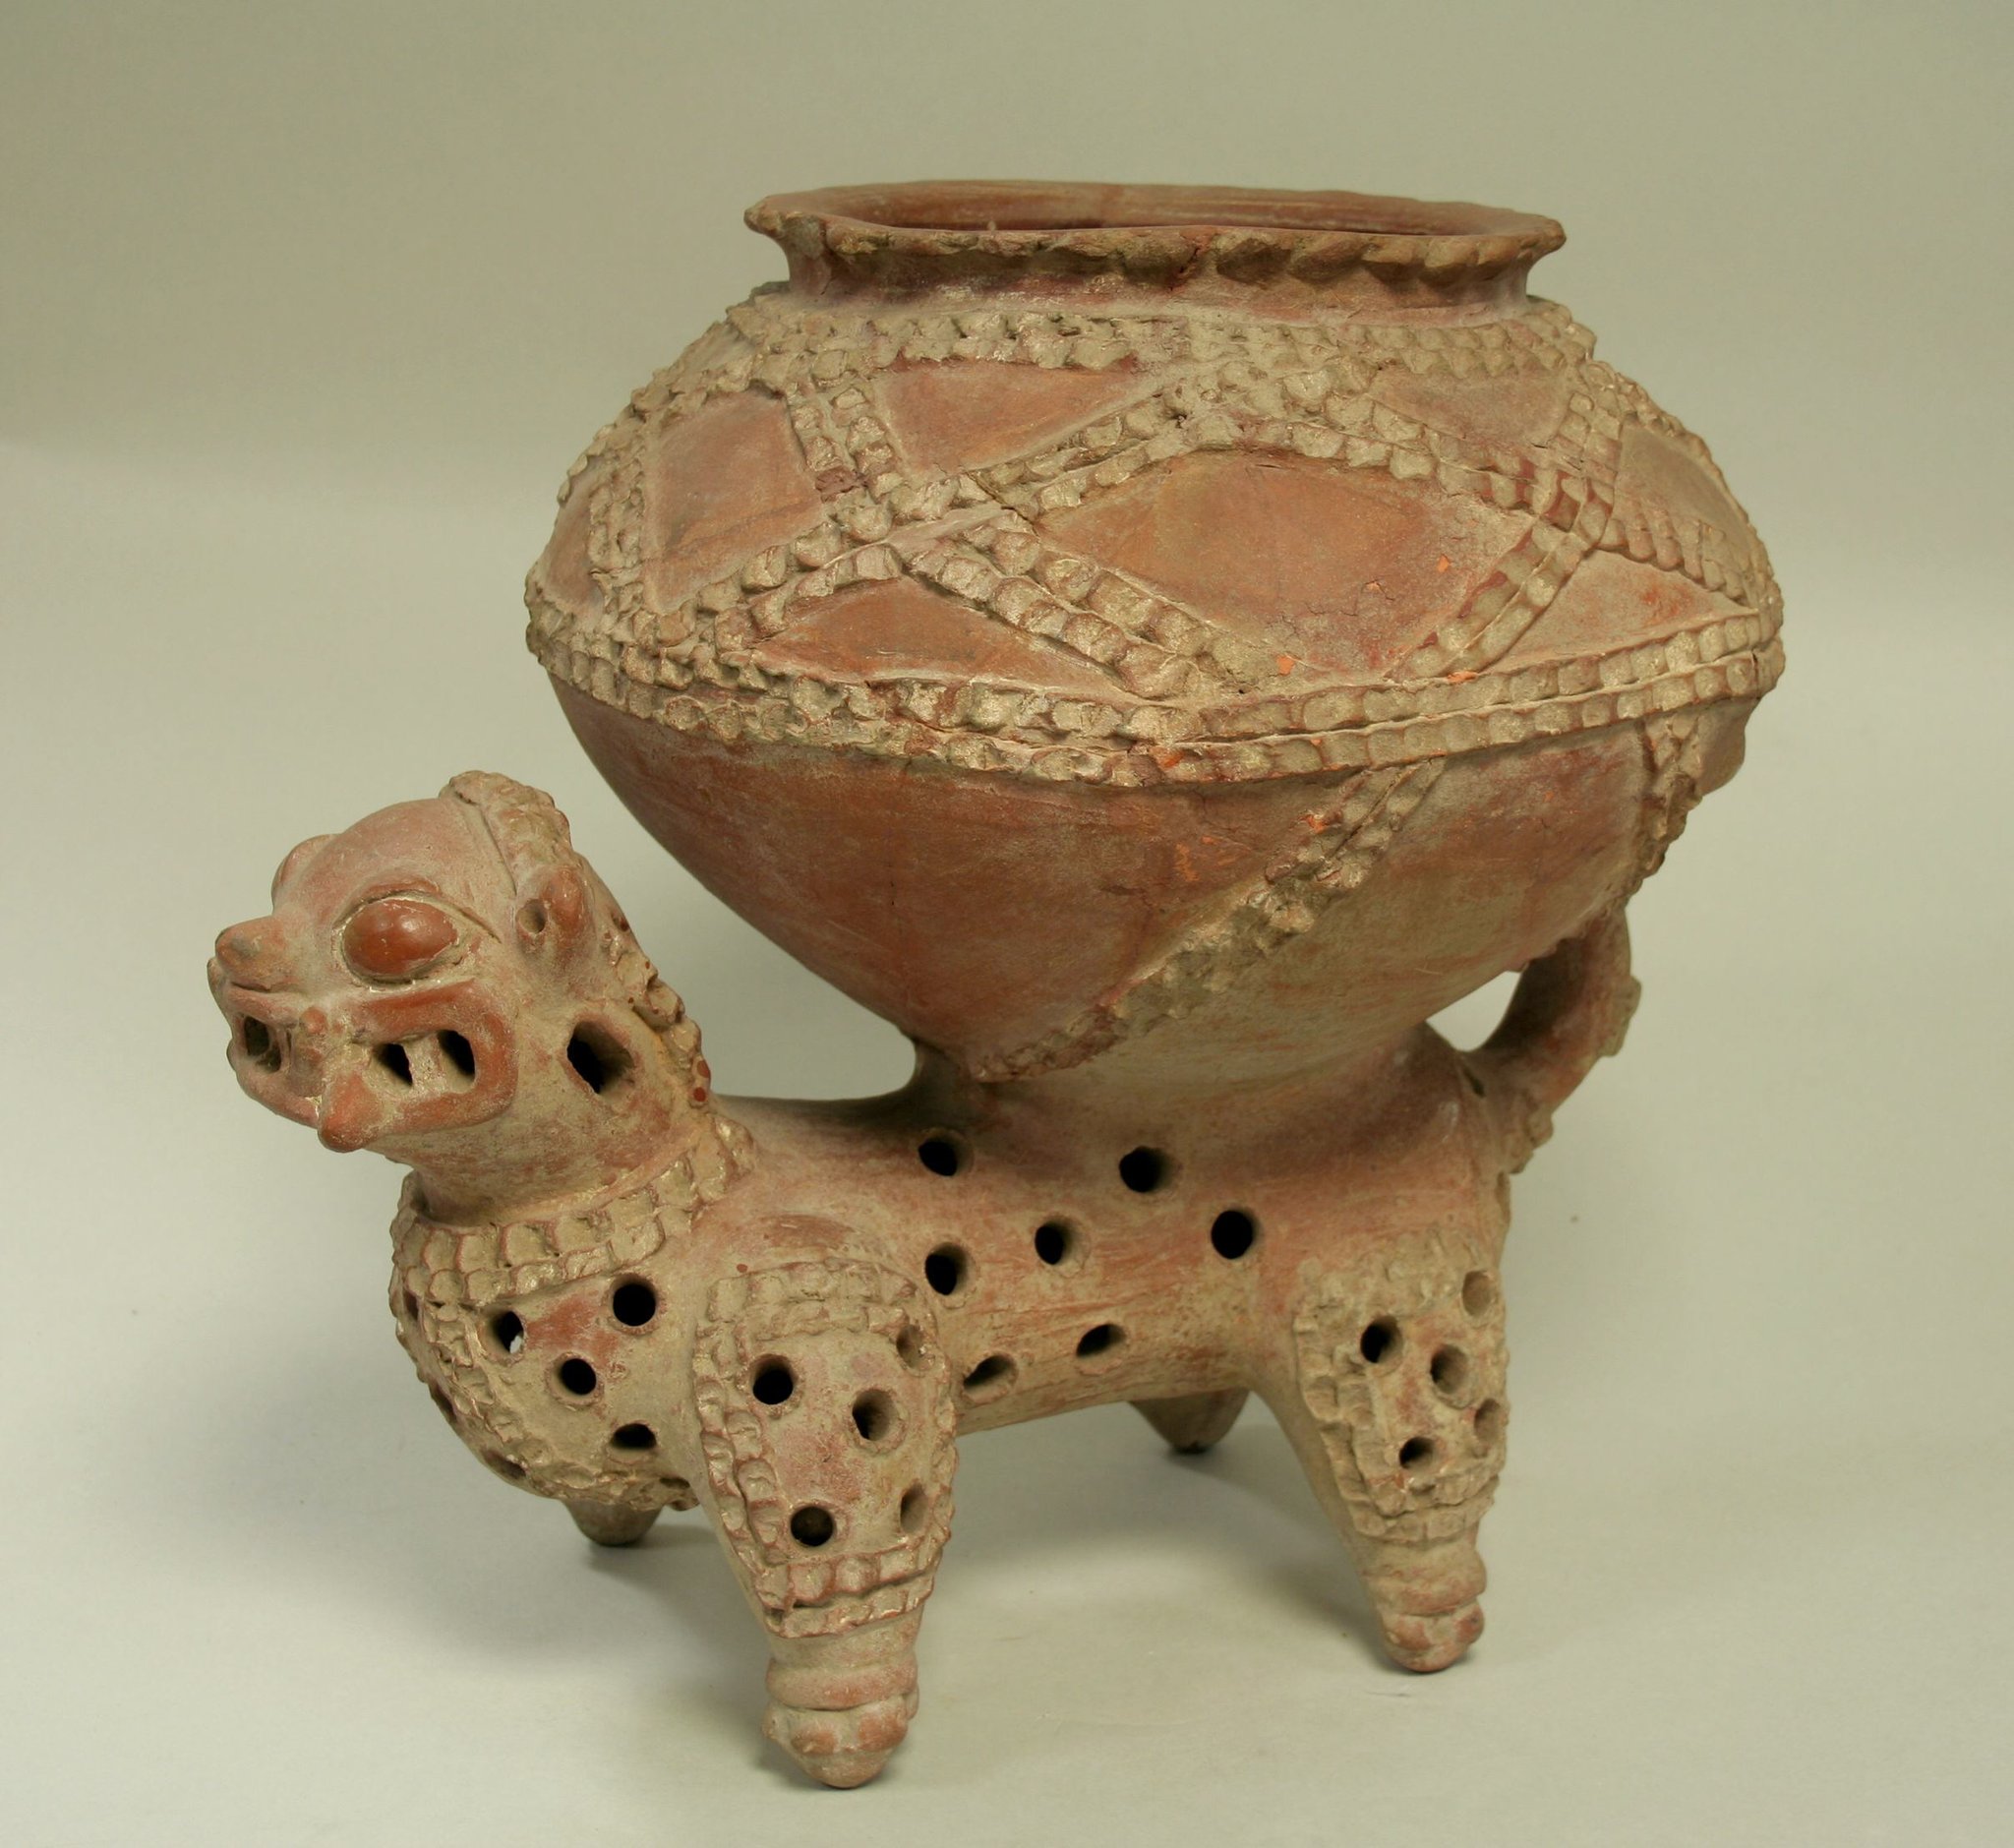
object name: bowl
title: Bowl Resting on Jaguar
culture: costa rican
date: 401-1600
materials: ceramic, pigment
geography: costa rica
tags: animals